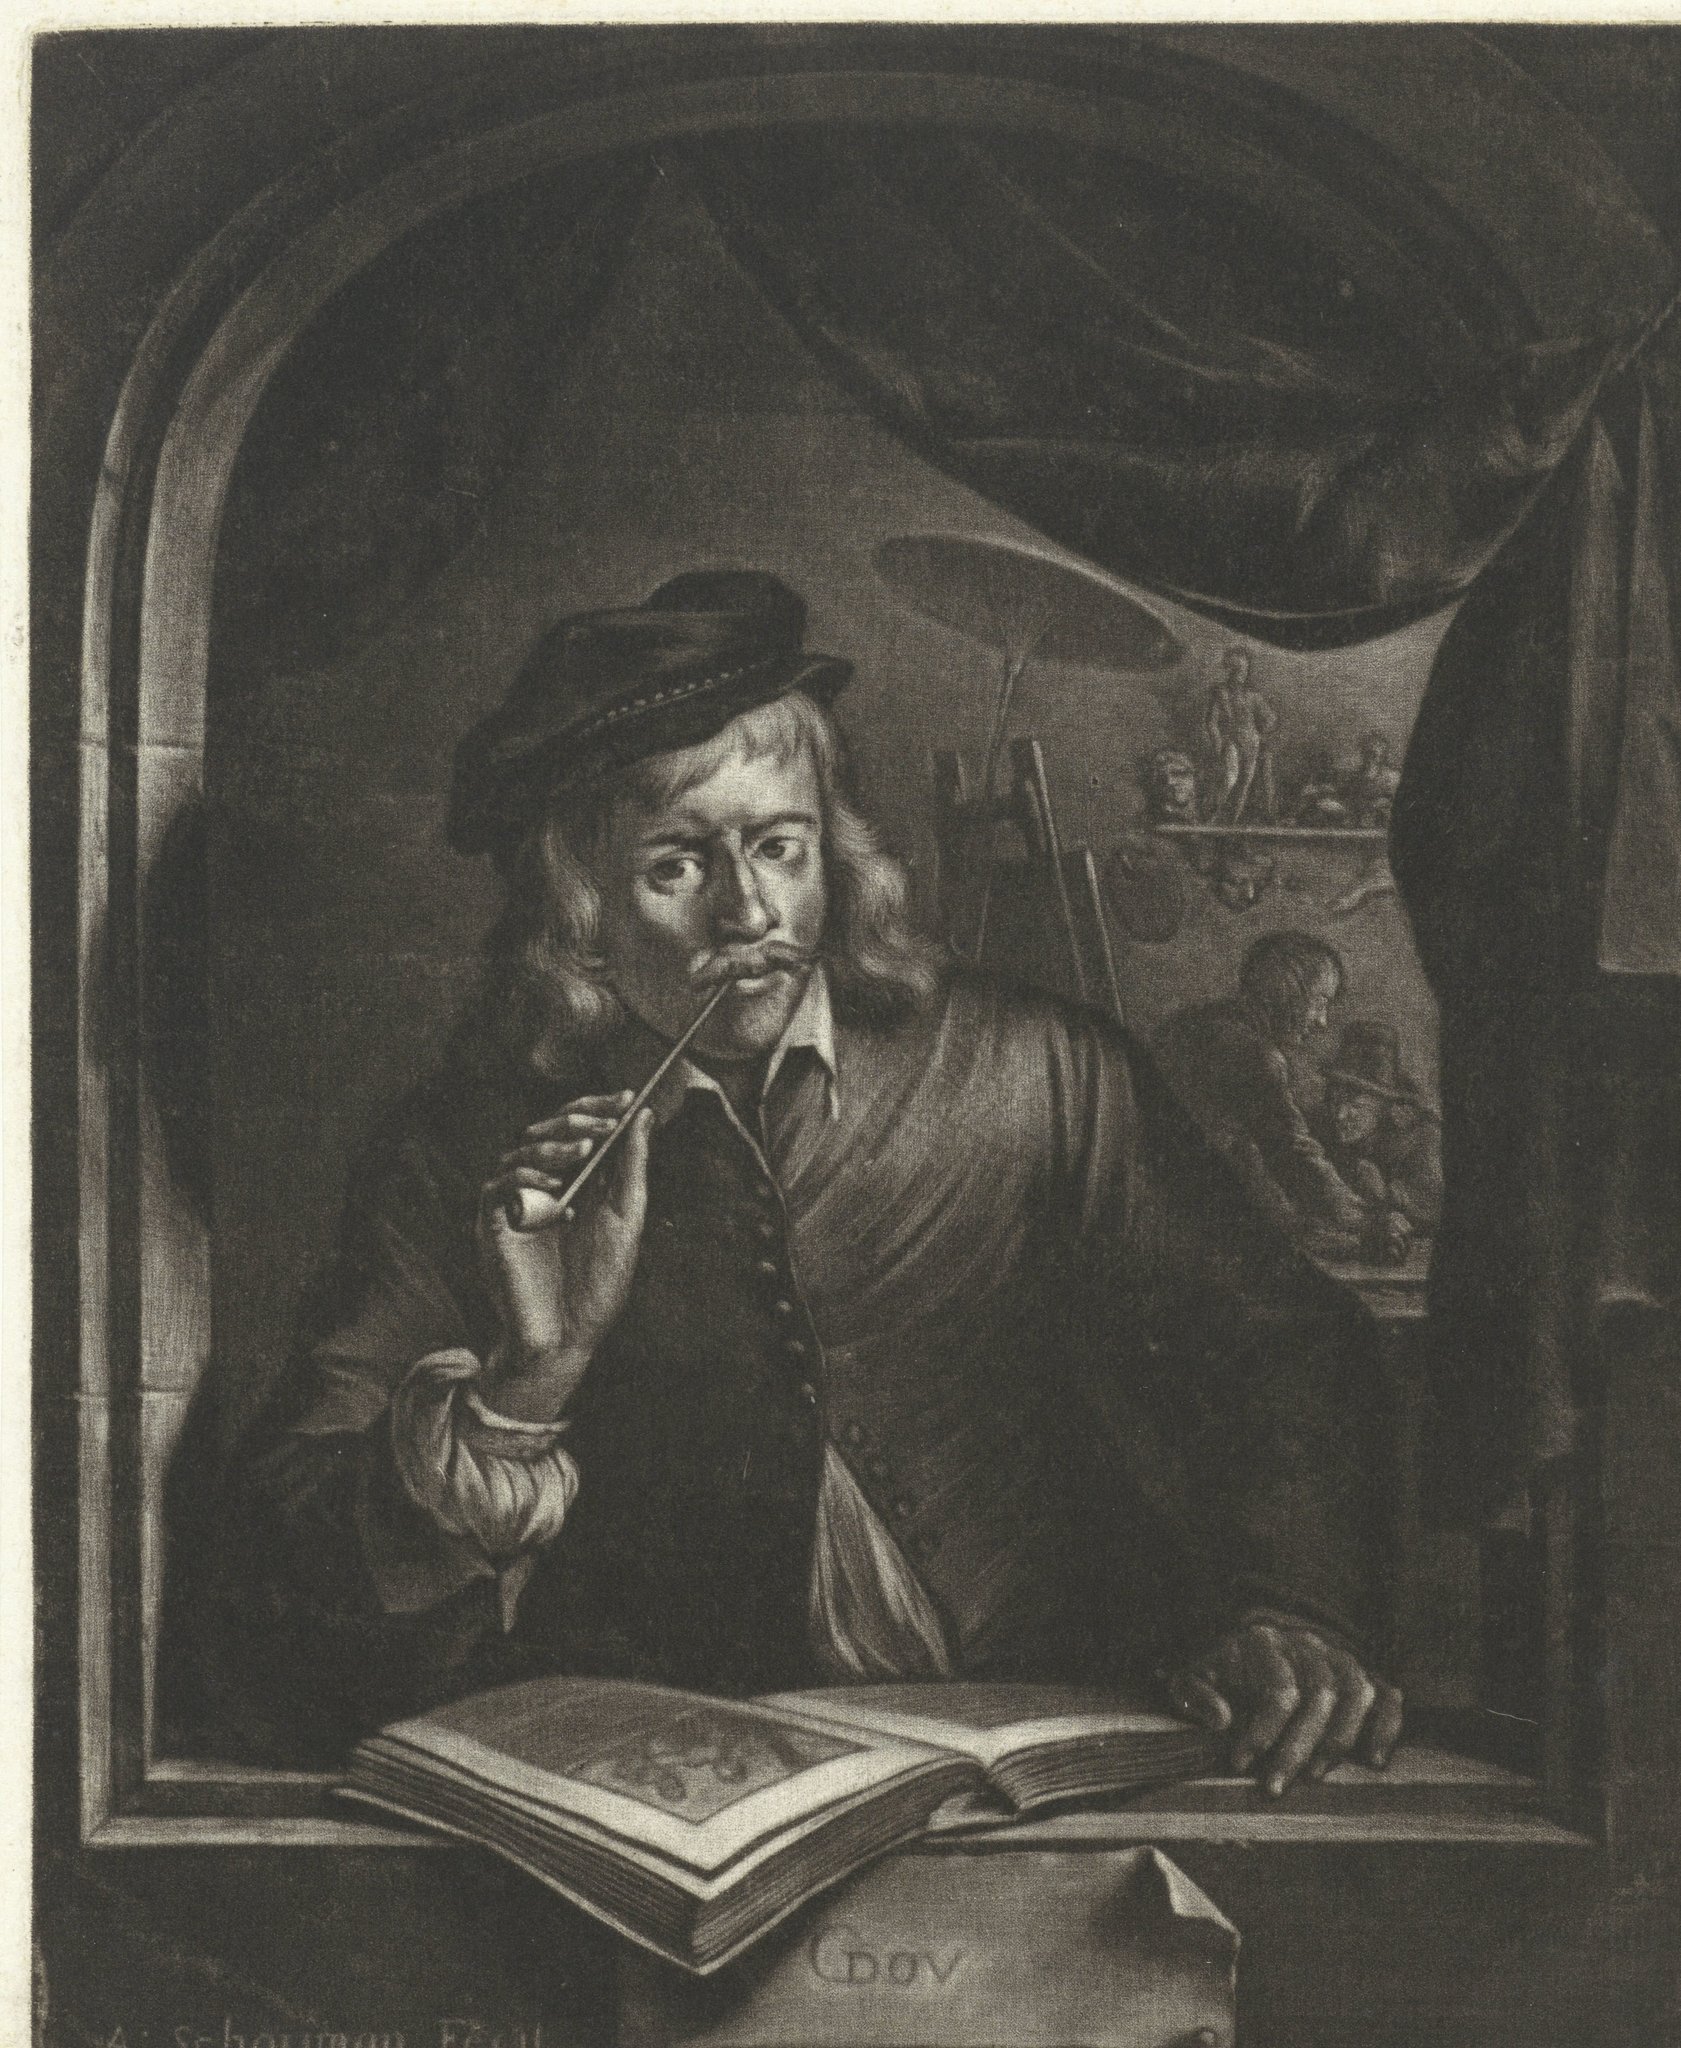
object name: print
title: Zelfportret van Gerard Dou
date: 1720-1792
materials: paper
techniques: mezzotint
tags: leiden, painter, draughtsman, gerard dou, pipe ~ tobacco, workshop, studio ~ painter, book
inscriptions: collector's mark: Lugt 2228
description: De schilder Gerard Dou rookt een pijp in het venster van een schilderswerkplaats. Voor hem ligt een boek en in het atelier zijn twee figuren aan het werk.